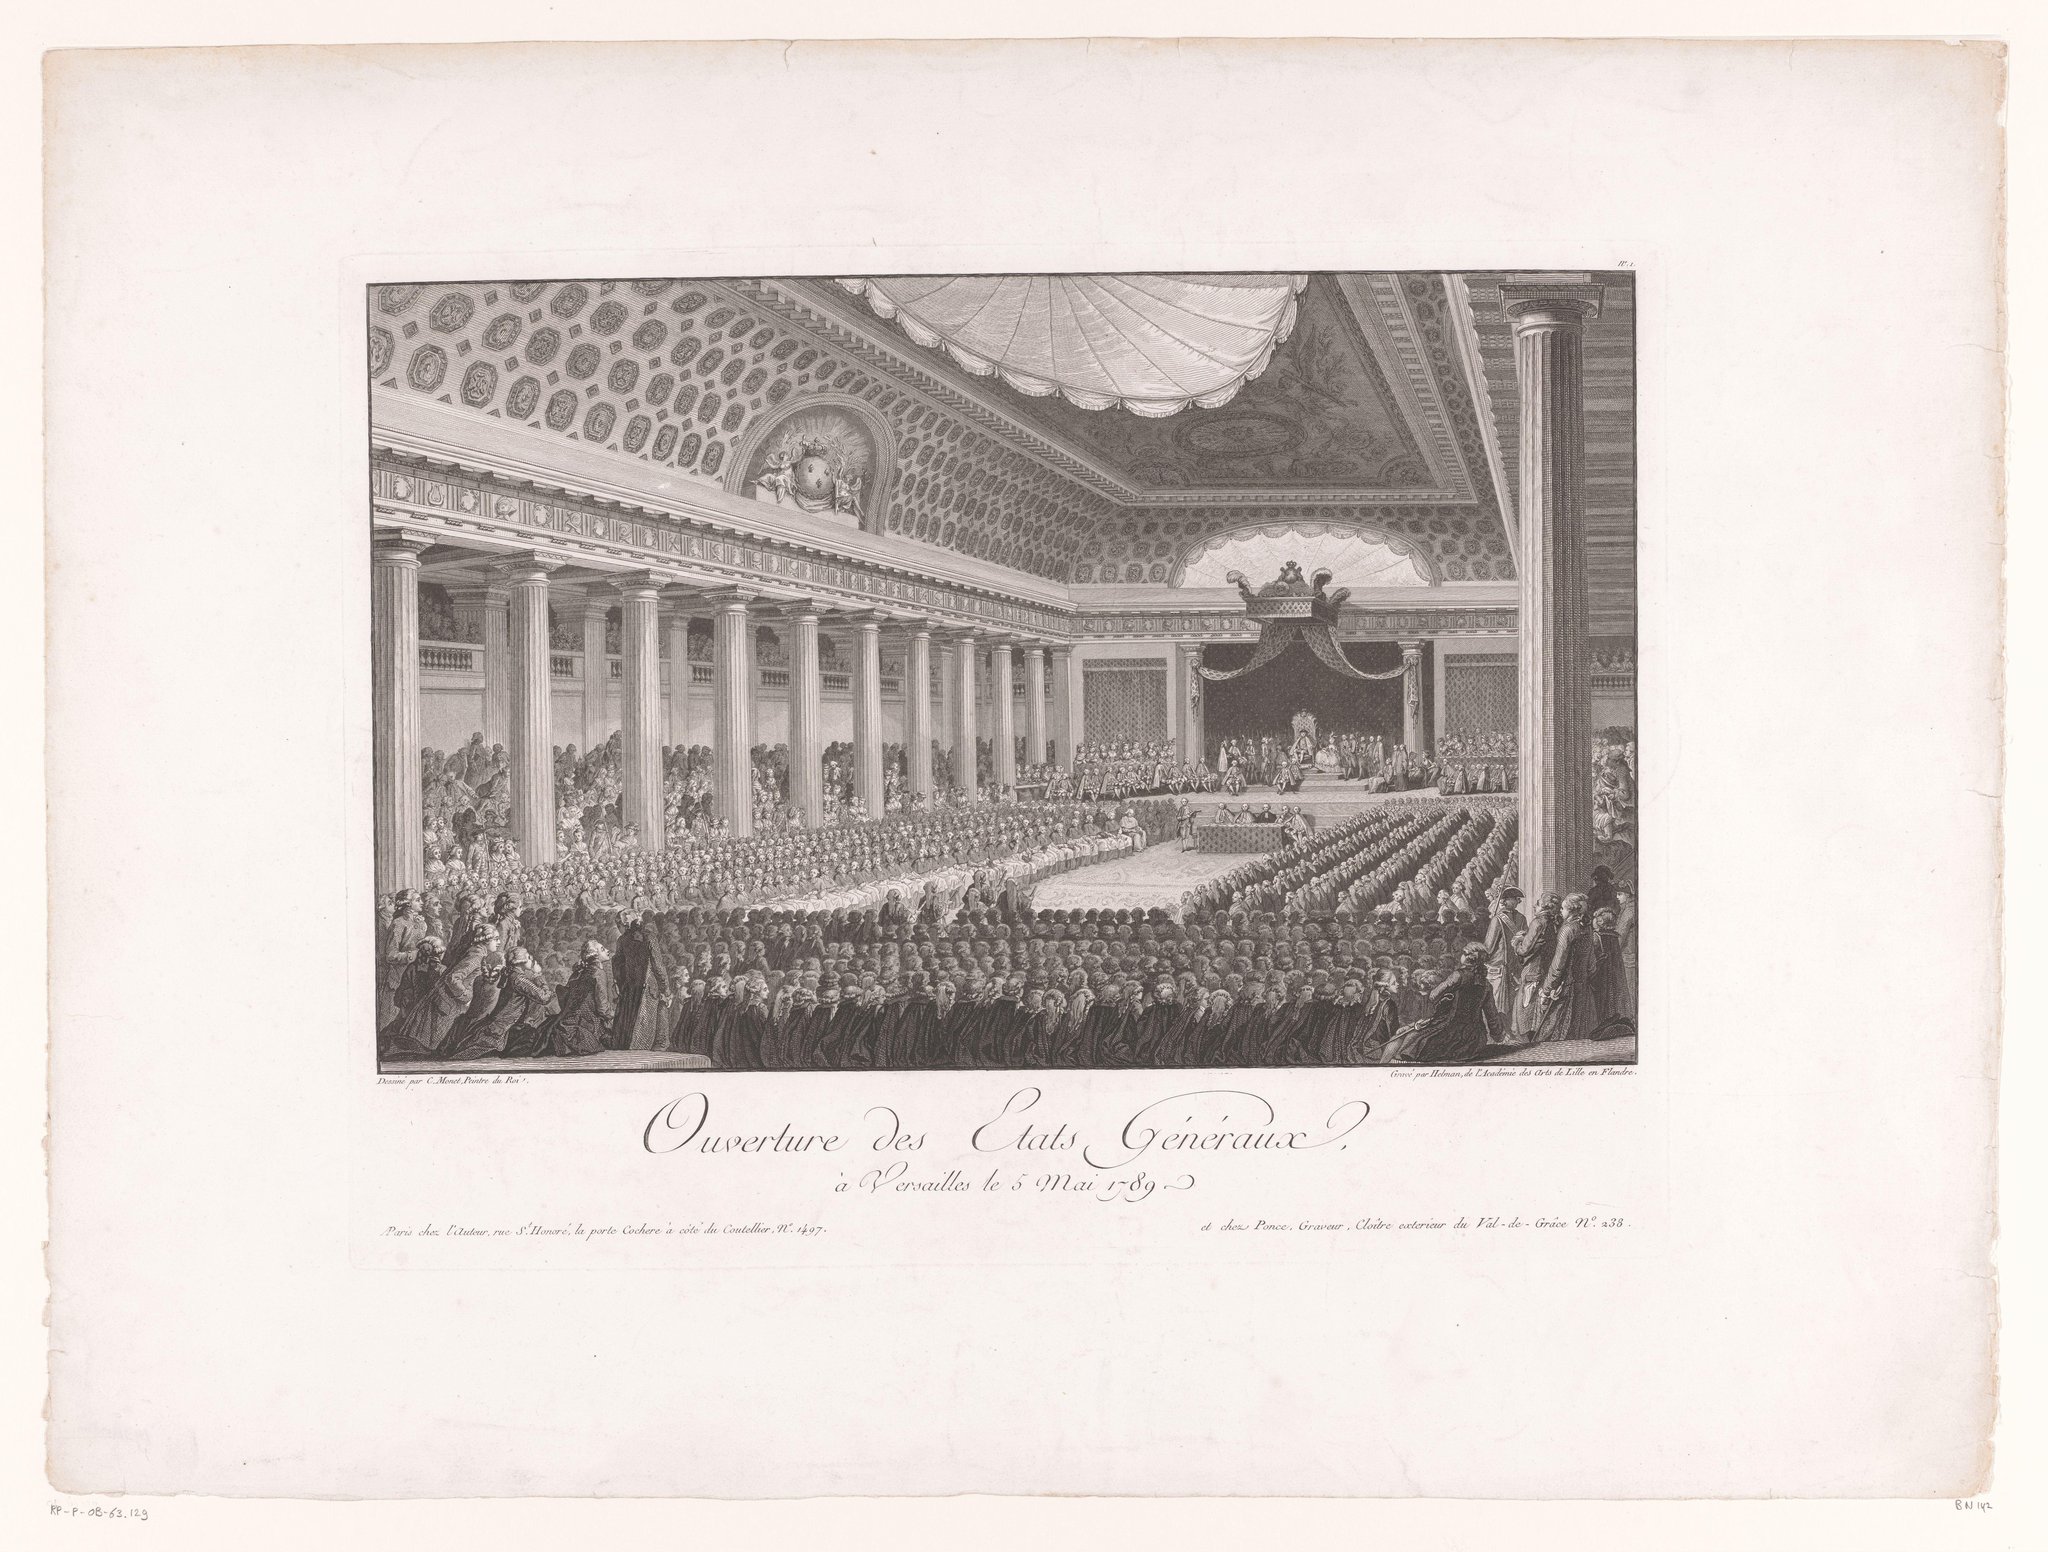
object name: print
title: Opening van de Staten-Generaal in Versailles, 5 mei 1789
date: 1793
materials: paper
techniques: etching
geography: france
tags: meeting, assembly, symbols of the state (in general)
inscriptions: collector's mark: Lugt 2228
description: Maakt deel uit van een serie getiteld 'La Révolution française depuis l'ouverture des États géneraux jusquáu 9 Brumaire' met vijftien prenten naar schilderijen met als onderwerp de eerste dagen van de Franse Revolutie. De serie werd verschillende malen uitgegeven, aanvankelijk onder de titel 'Les principales journées de la Révolution'. Voor meer informatie zie IFF 18e siècle, dl. 11, p. 291.